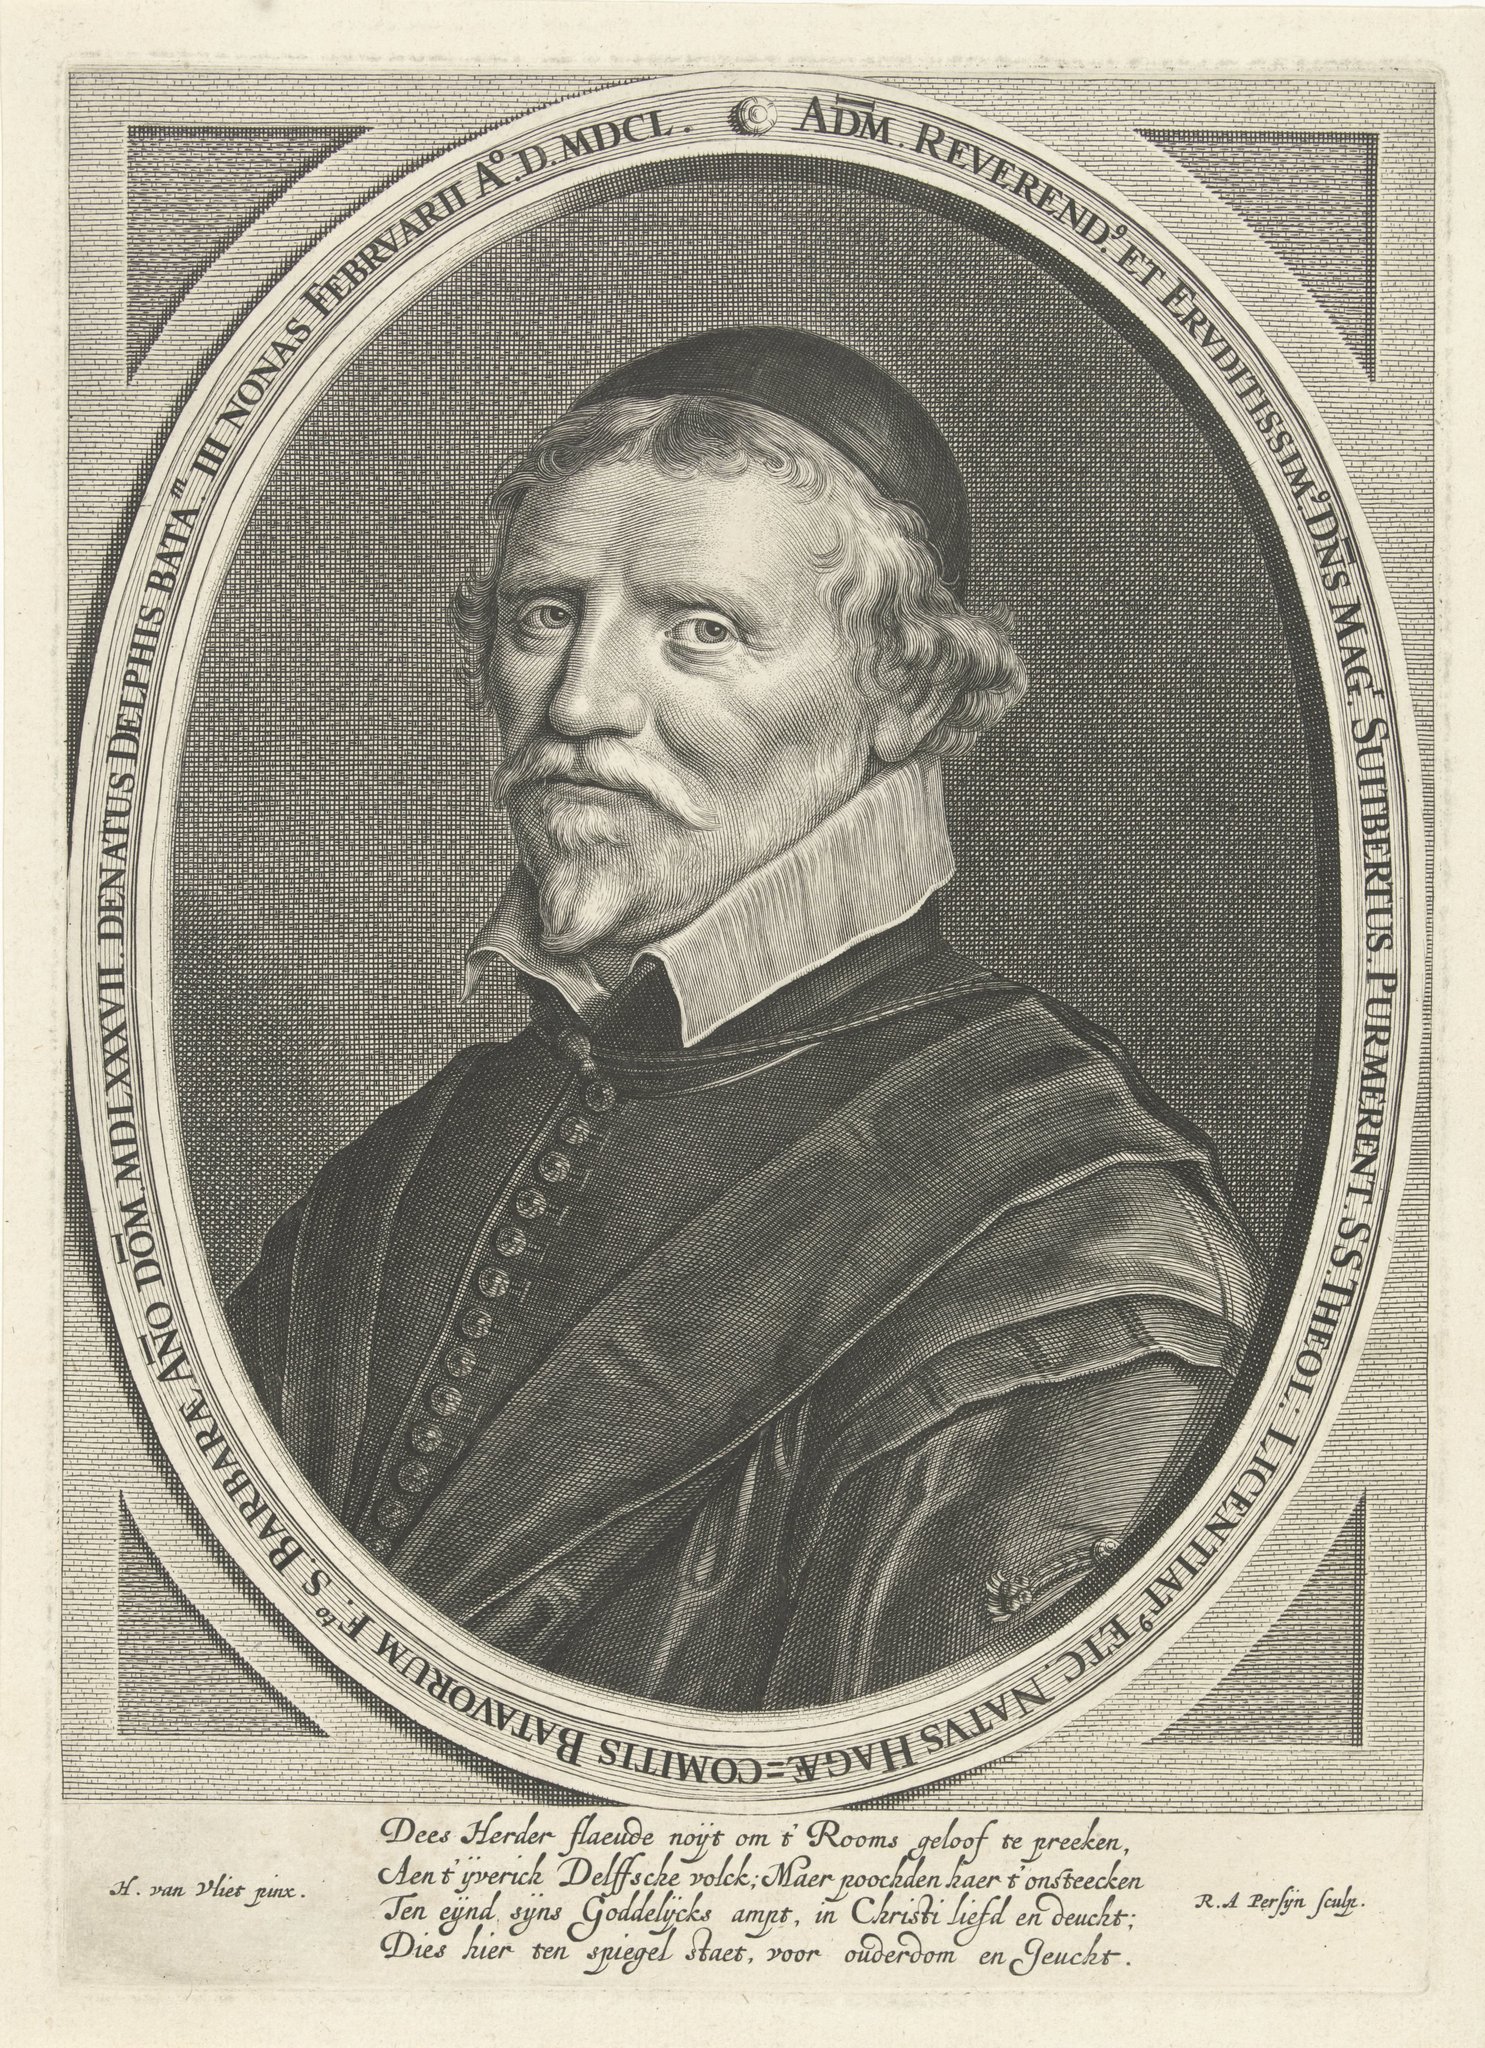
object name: print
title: Portret van Suitbertus Purmerent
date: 1650-1668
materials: paper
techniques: engraving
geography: gouda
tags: the hague, delft, priest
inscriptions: collector's mark: Lugt 2228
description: Portret van Suitbertus Purmerent, pastoor te Delft. In de marge een vierregelig lofdicht in het Nederlands. Pendant van een portret van zijn tweelingbroer.